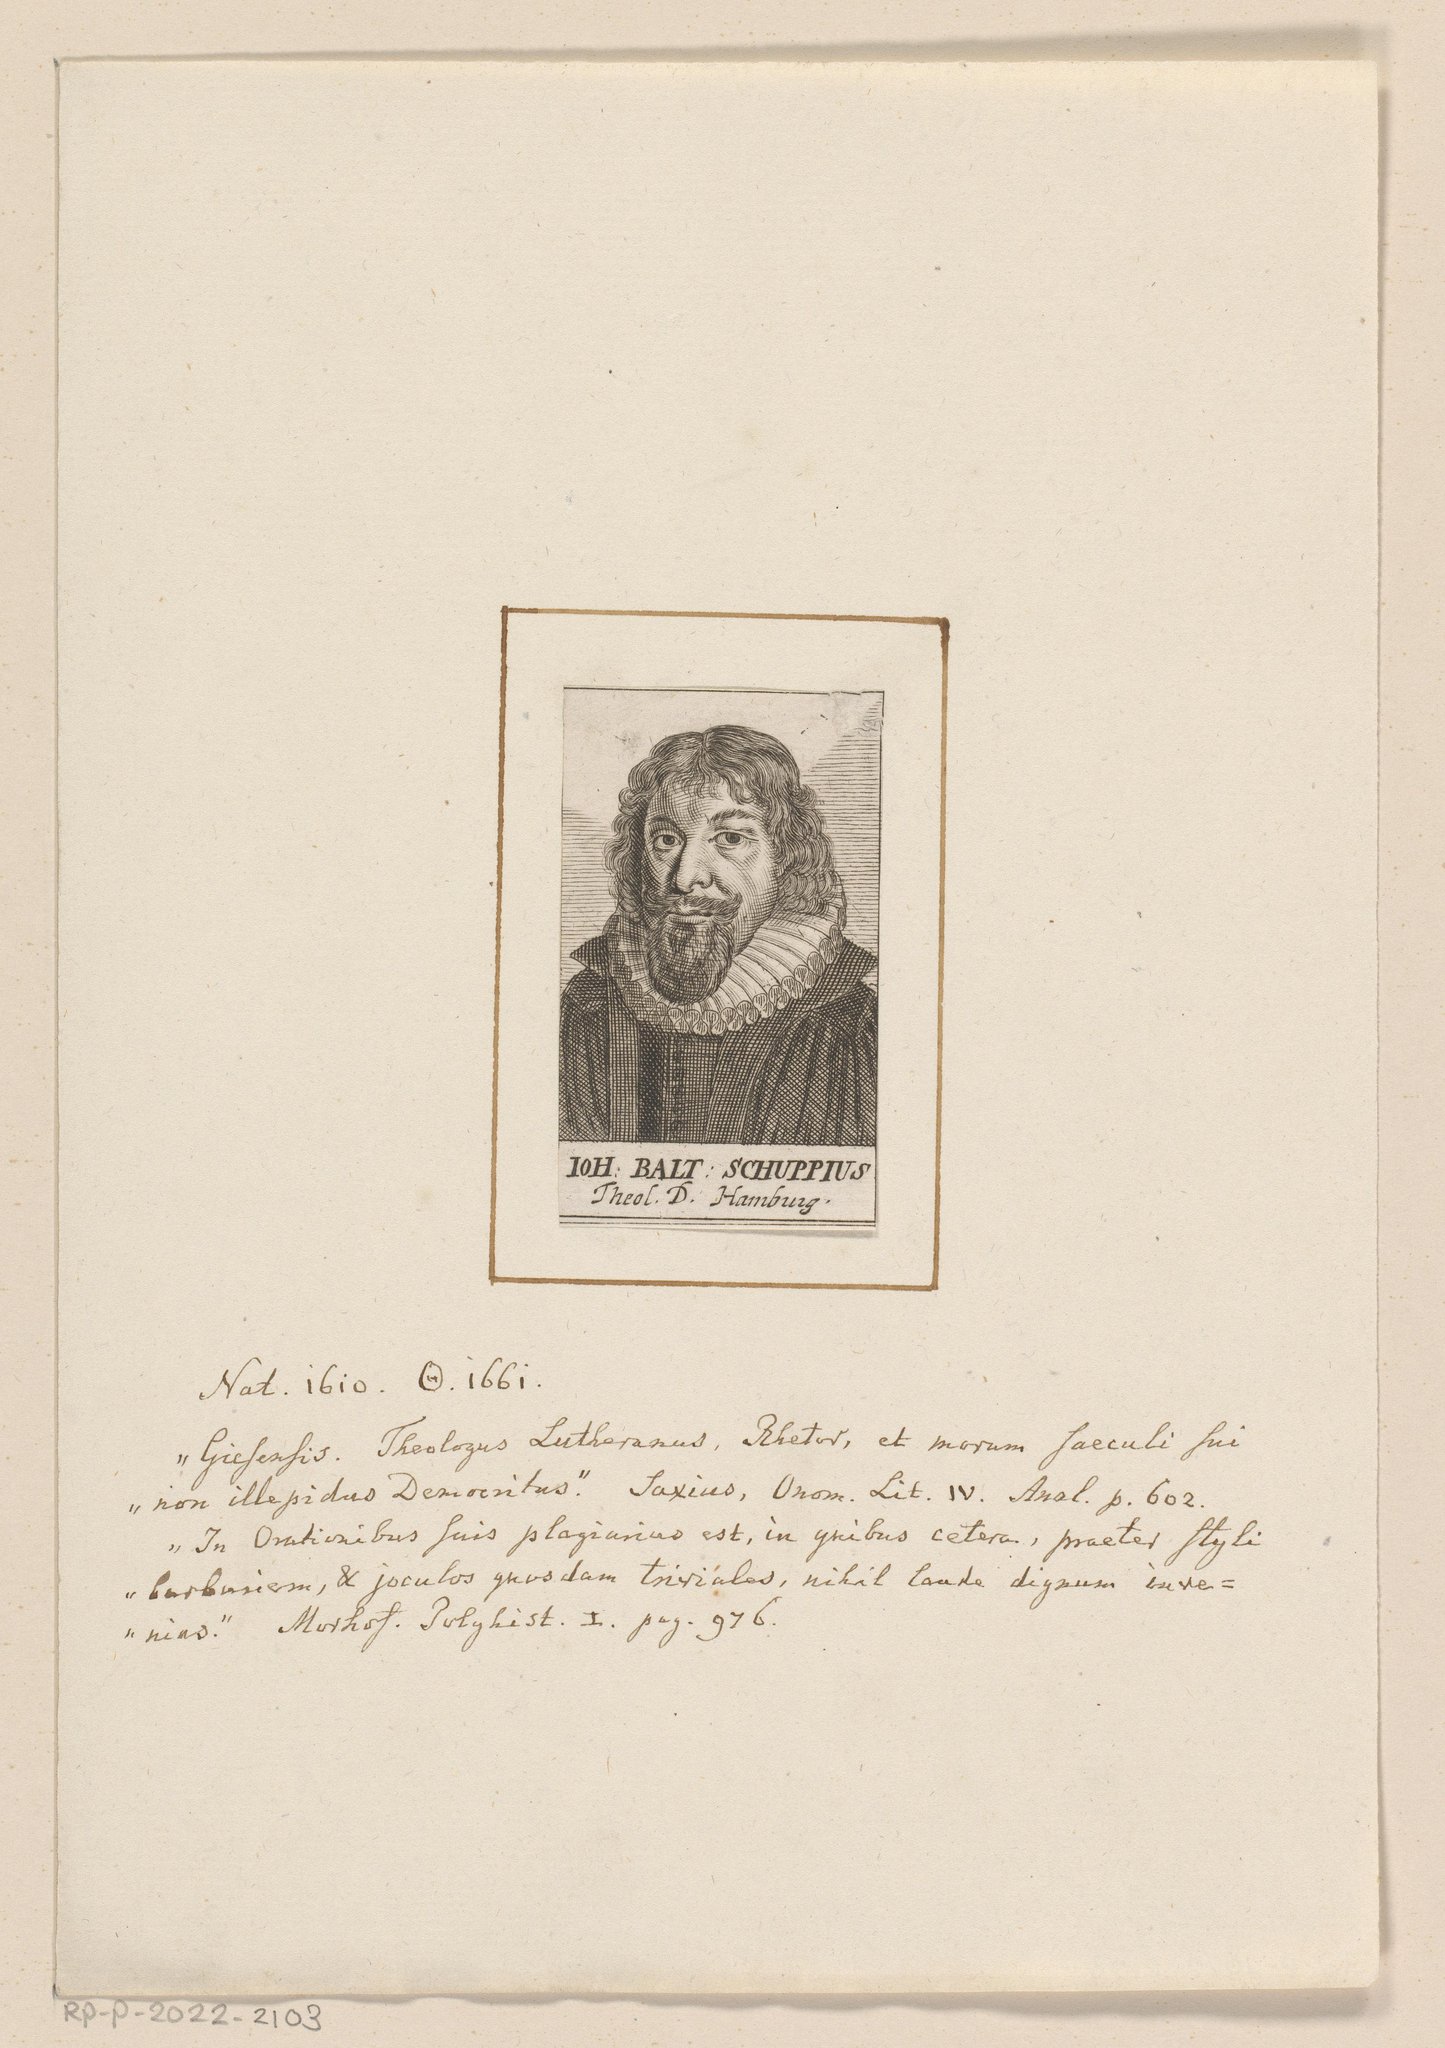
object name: print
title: Portret van Johann Balthasar Schupp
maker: Anonymous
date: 1688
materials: ink, paper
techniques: engraving, etching, pen, snipping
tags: theologian, historical persons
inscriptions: inscription: ‘Nat. 1610. O. (...) I pag. 976.’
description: Prent uit: Freher, Paul. Theatrum virorum eruditione clarorum. Neurenberg: Johann Hoffmann, 1688.